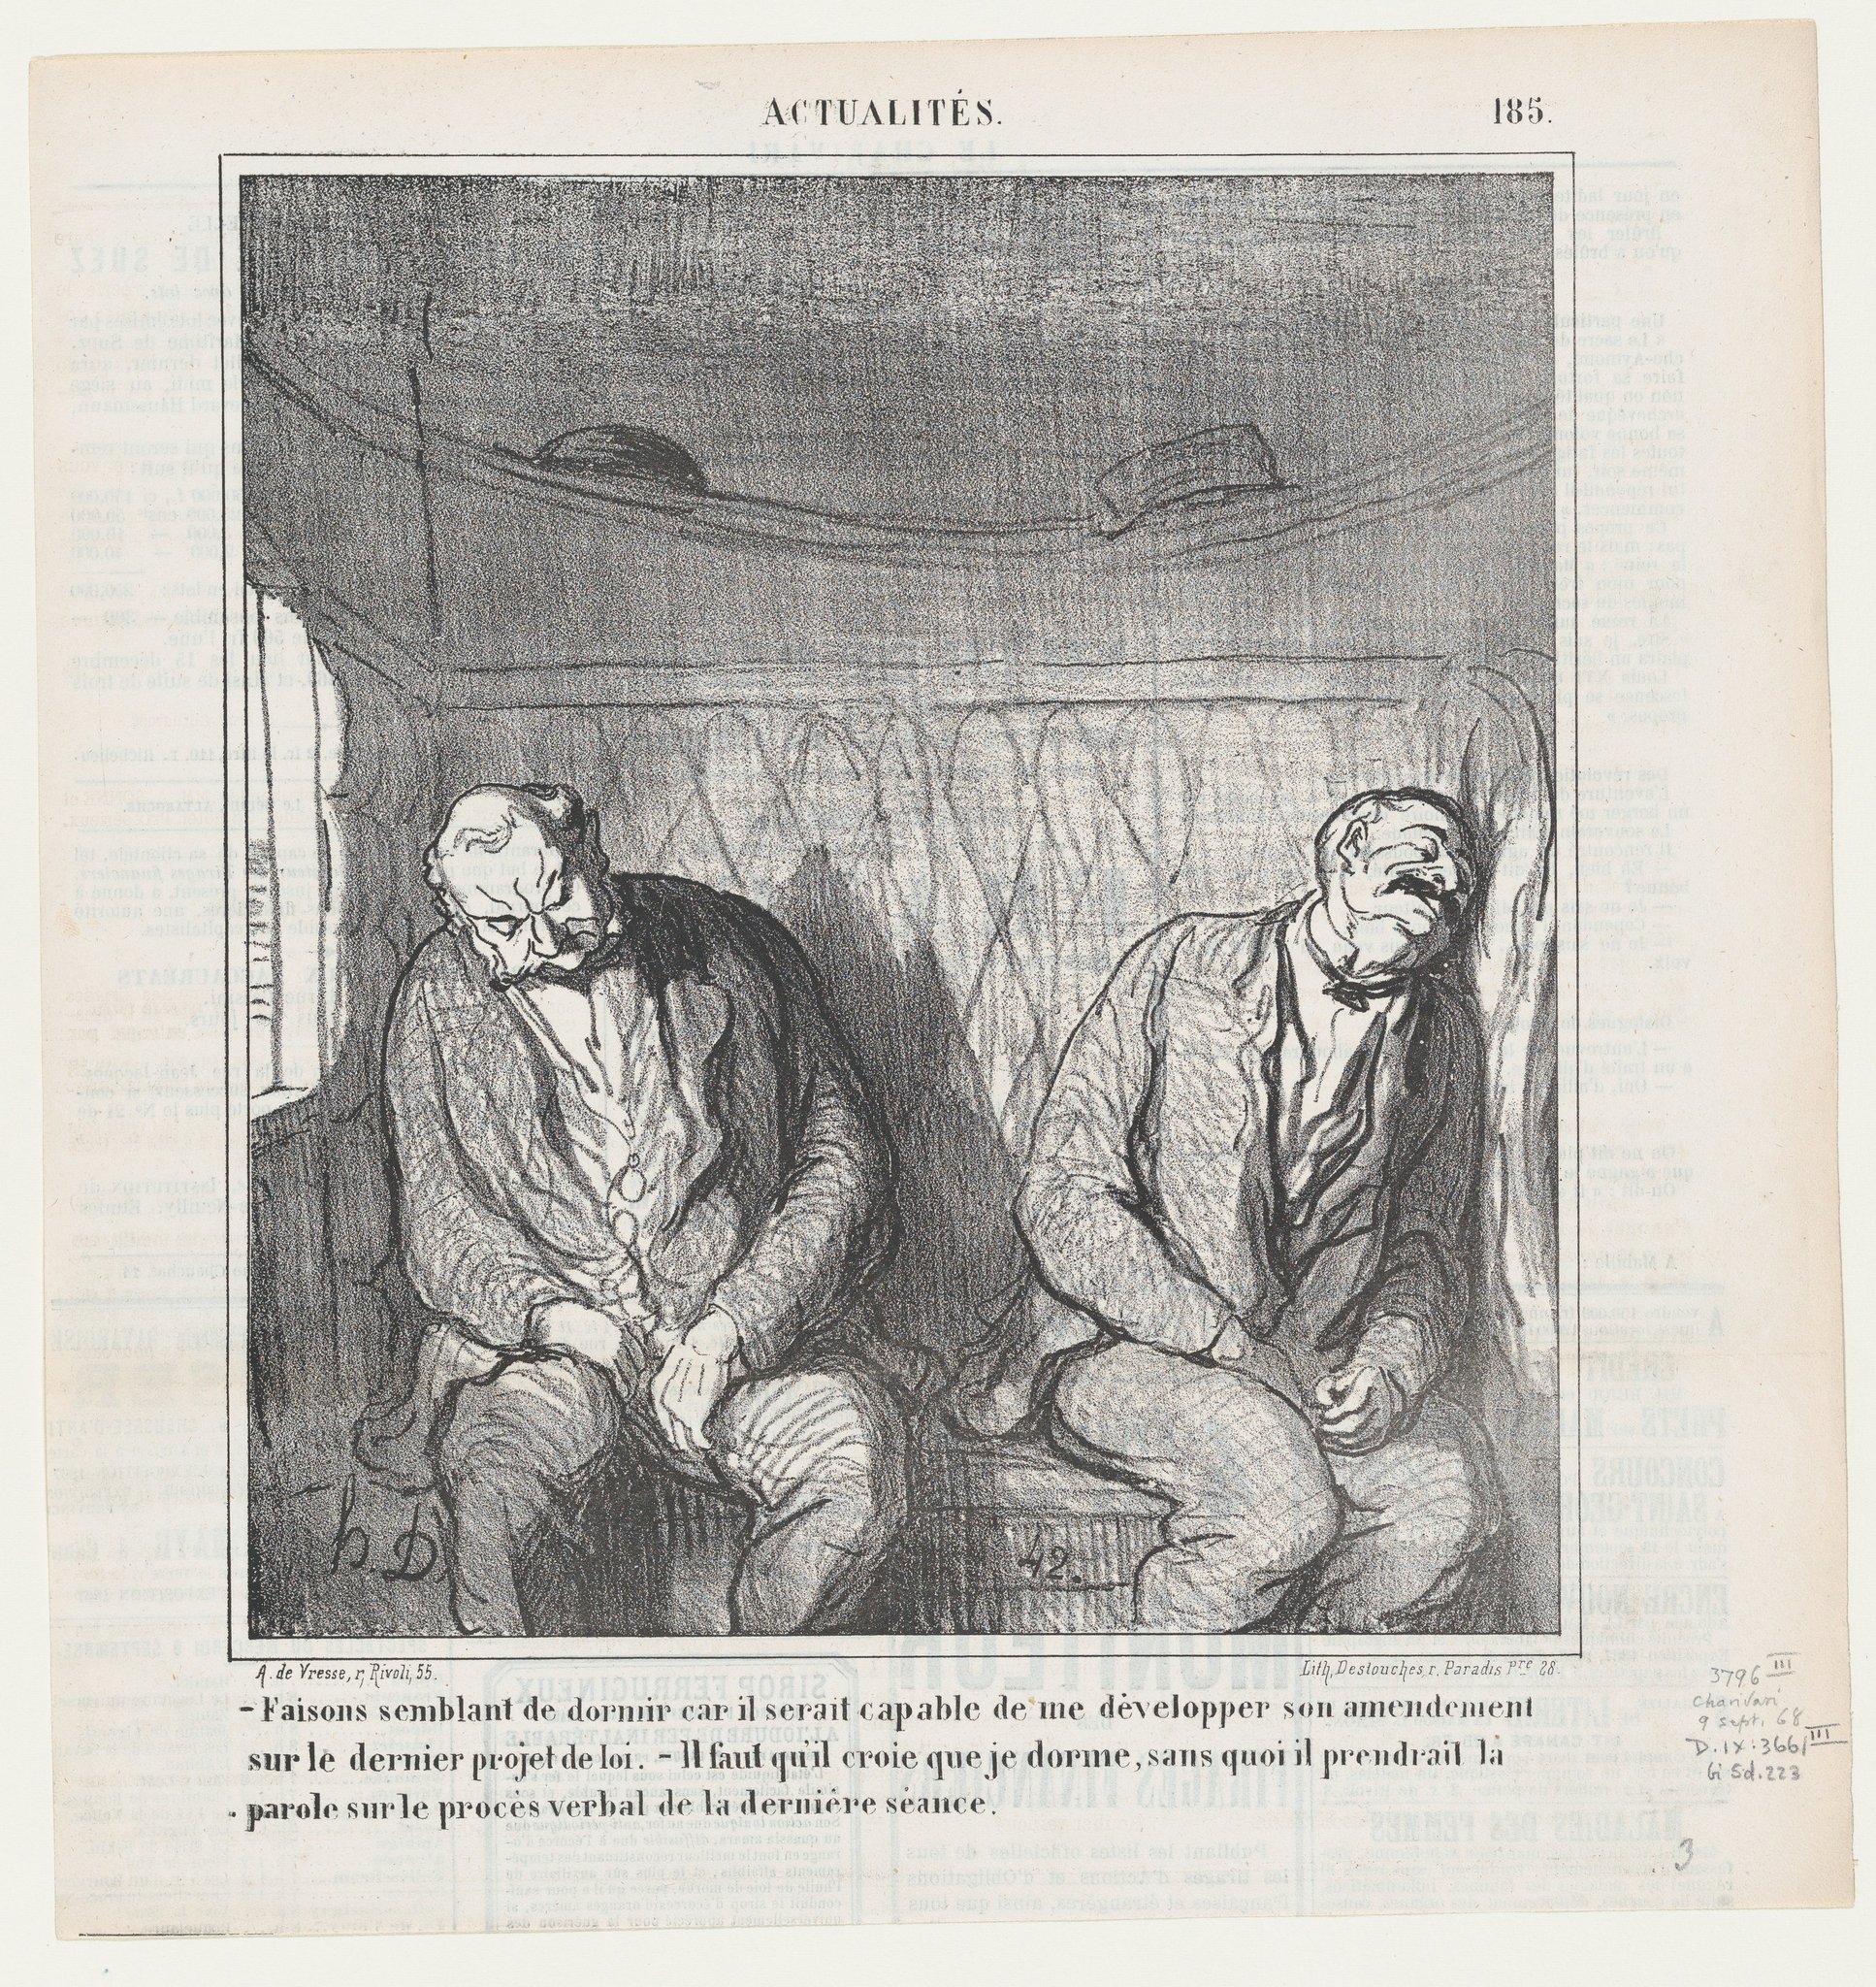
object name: print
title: –I'll pretend to be asleep, otherwise he will never stop explaining his plans for amending his latest bill. –I'll make him believe that I am asleep or he will go on and on about the minutes of the last session, from 'News of the day,' published in Le Charivari, September 9, 1868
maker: honoré daumier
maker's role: artist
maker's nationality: french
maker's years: 1808-1879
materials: paper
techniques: lithograph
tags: sleeping,men